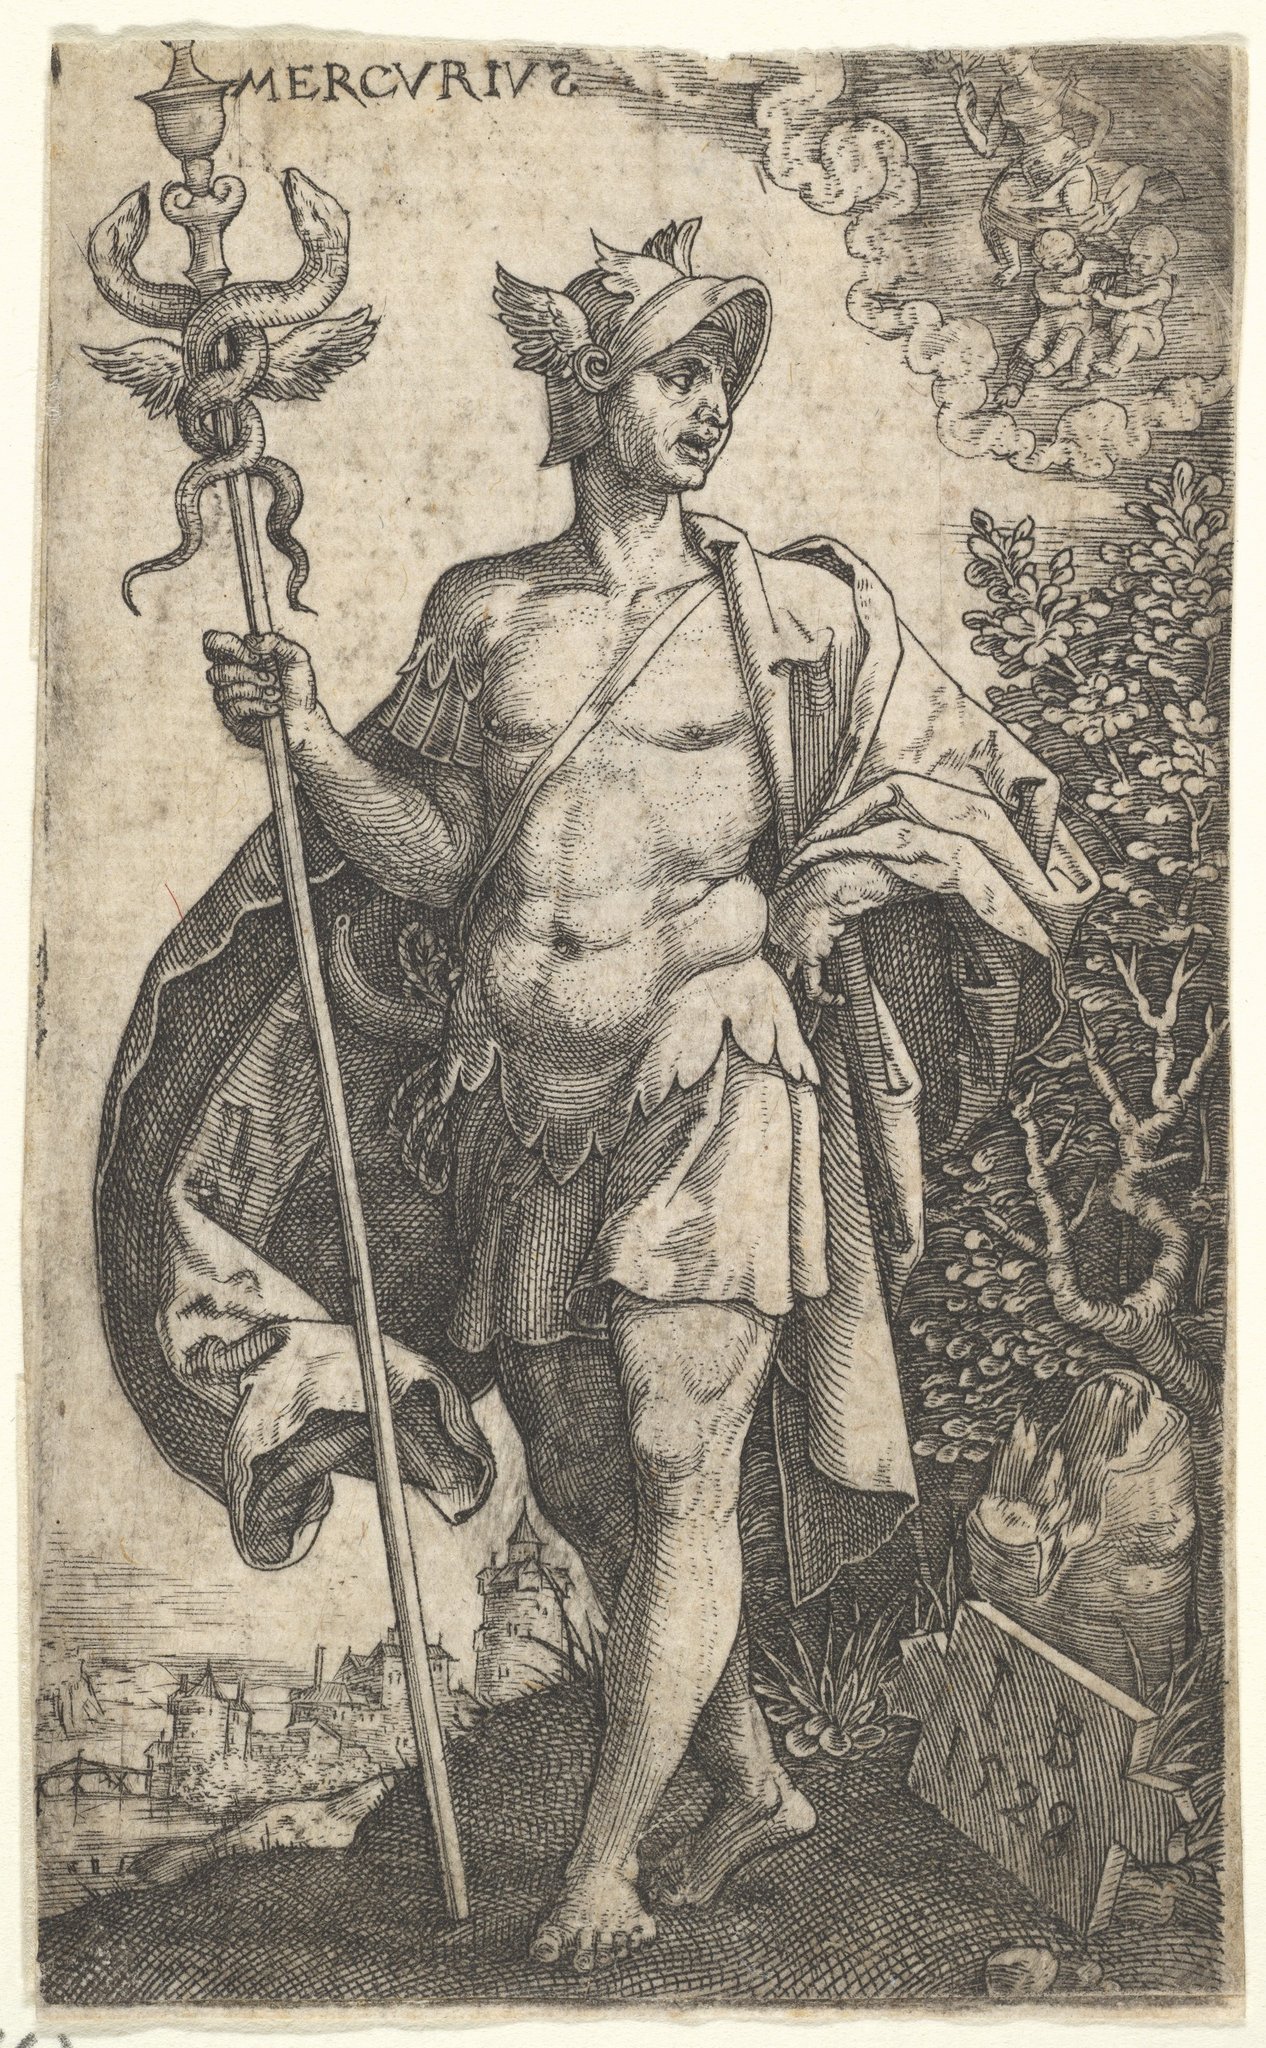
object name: print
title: Mercury, from "The Gods Who Preside Over the Planets"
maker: master i.b.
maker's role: artist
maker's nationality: german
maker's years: 1525-1530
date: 1528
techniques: etching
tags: mercury